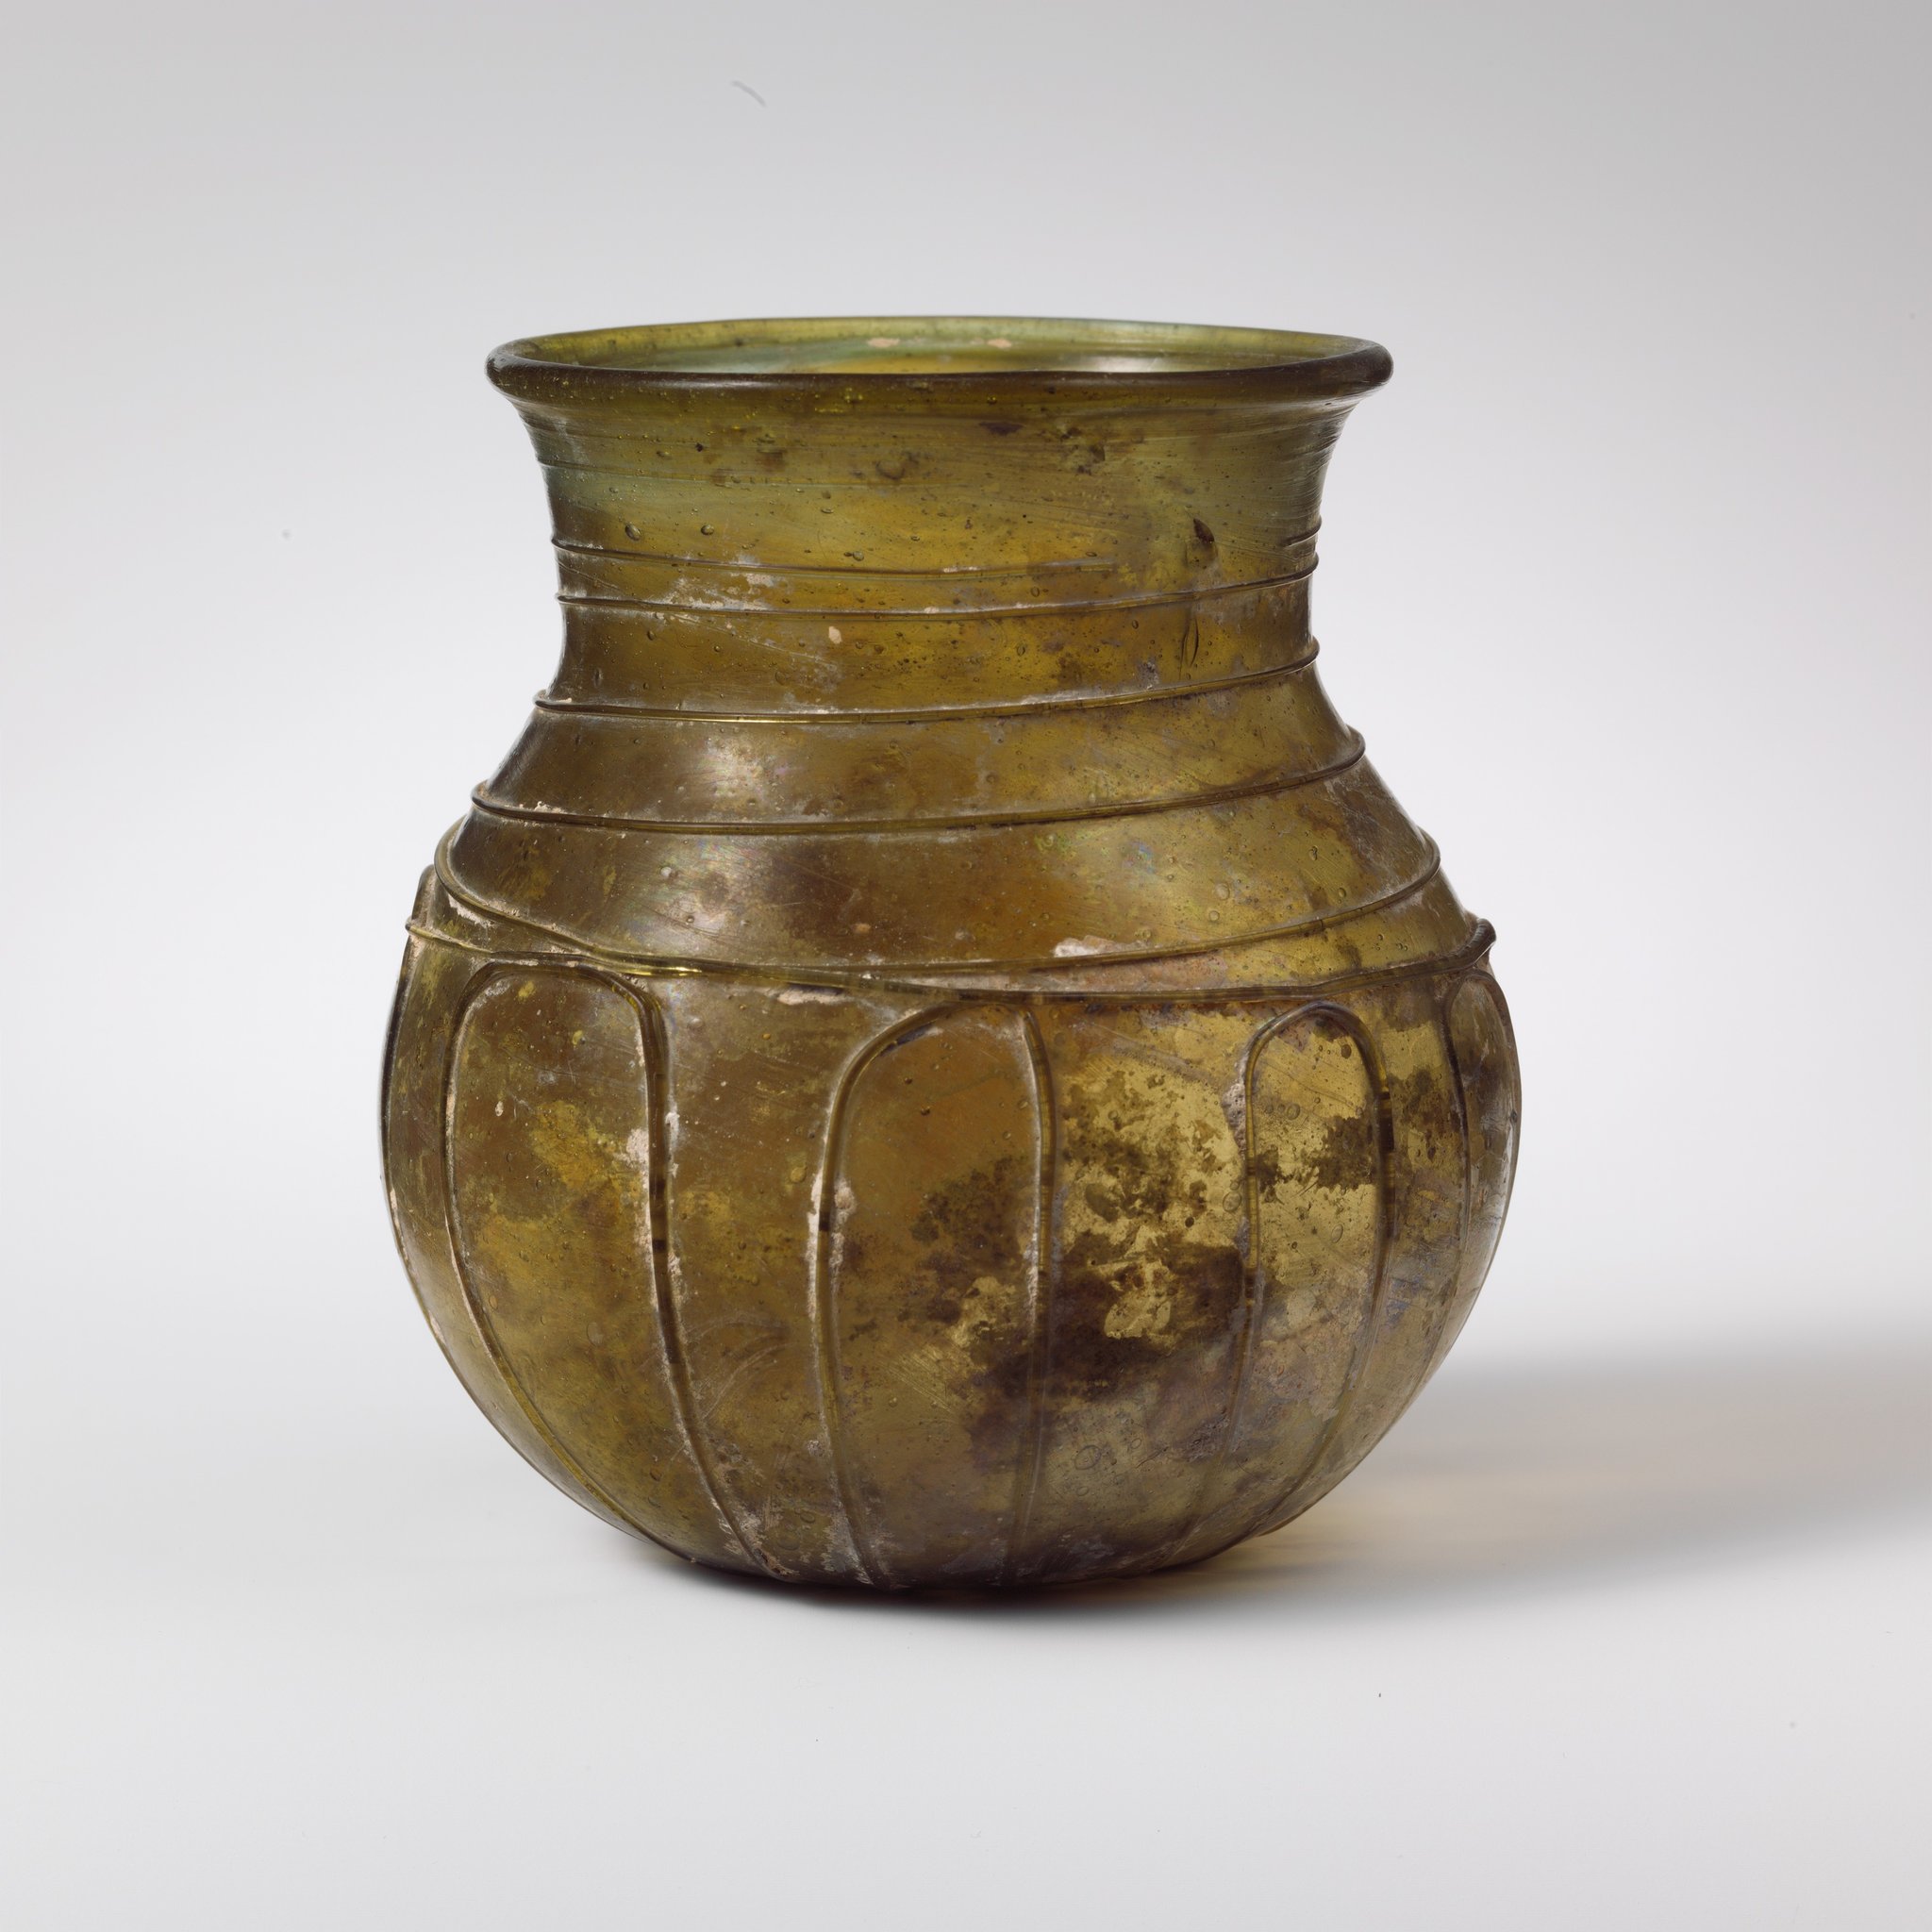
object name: jar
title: Glass jar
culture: roman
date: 201-400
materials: glass